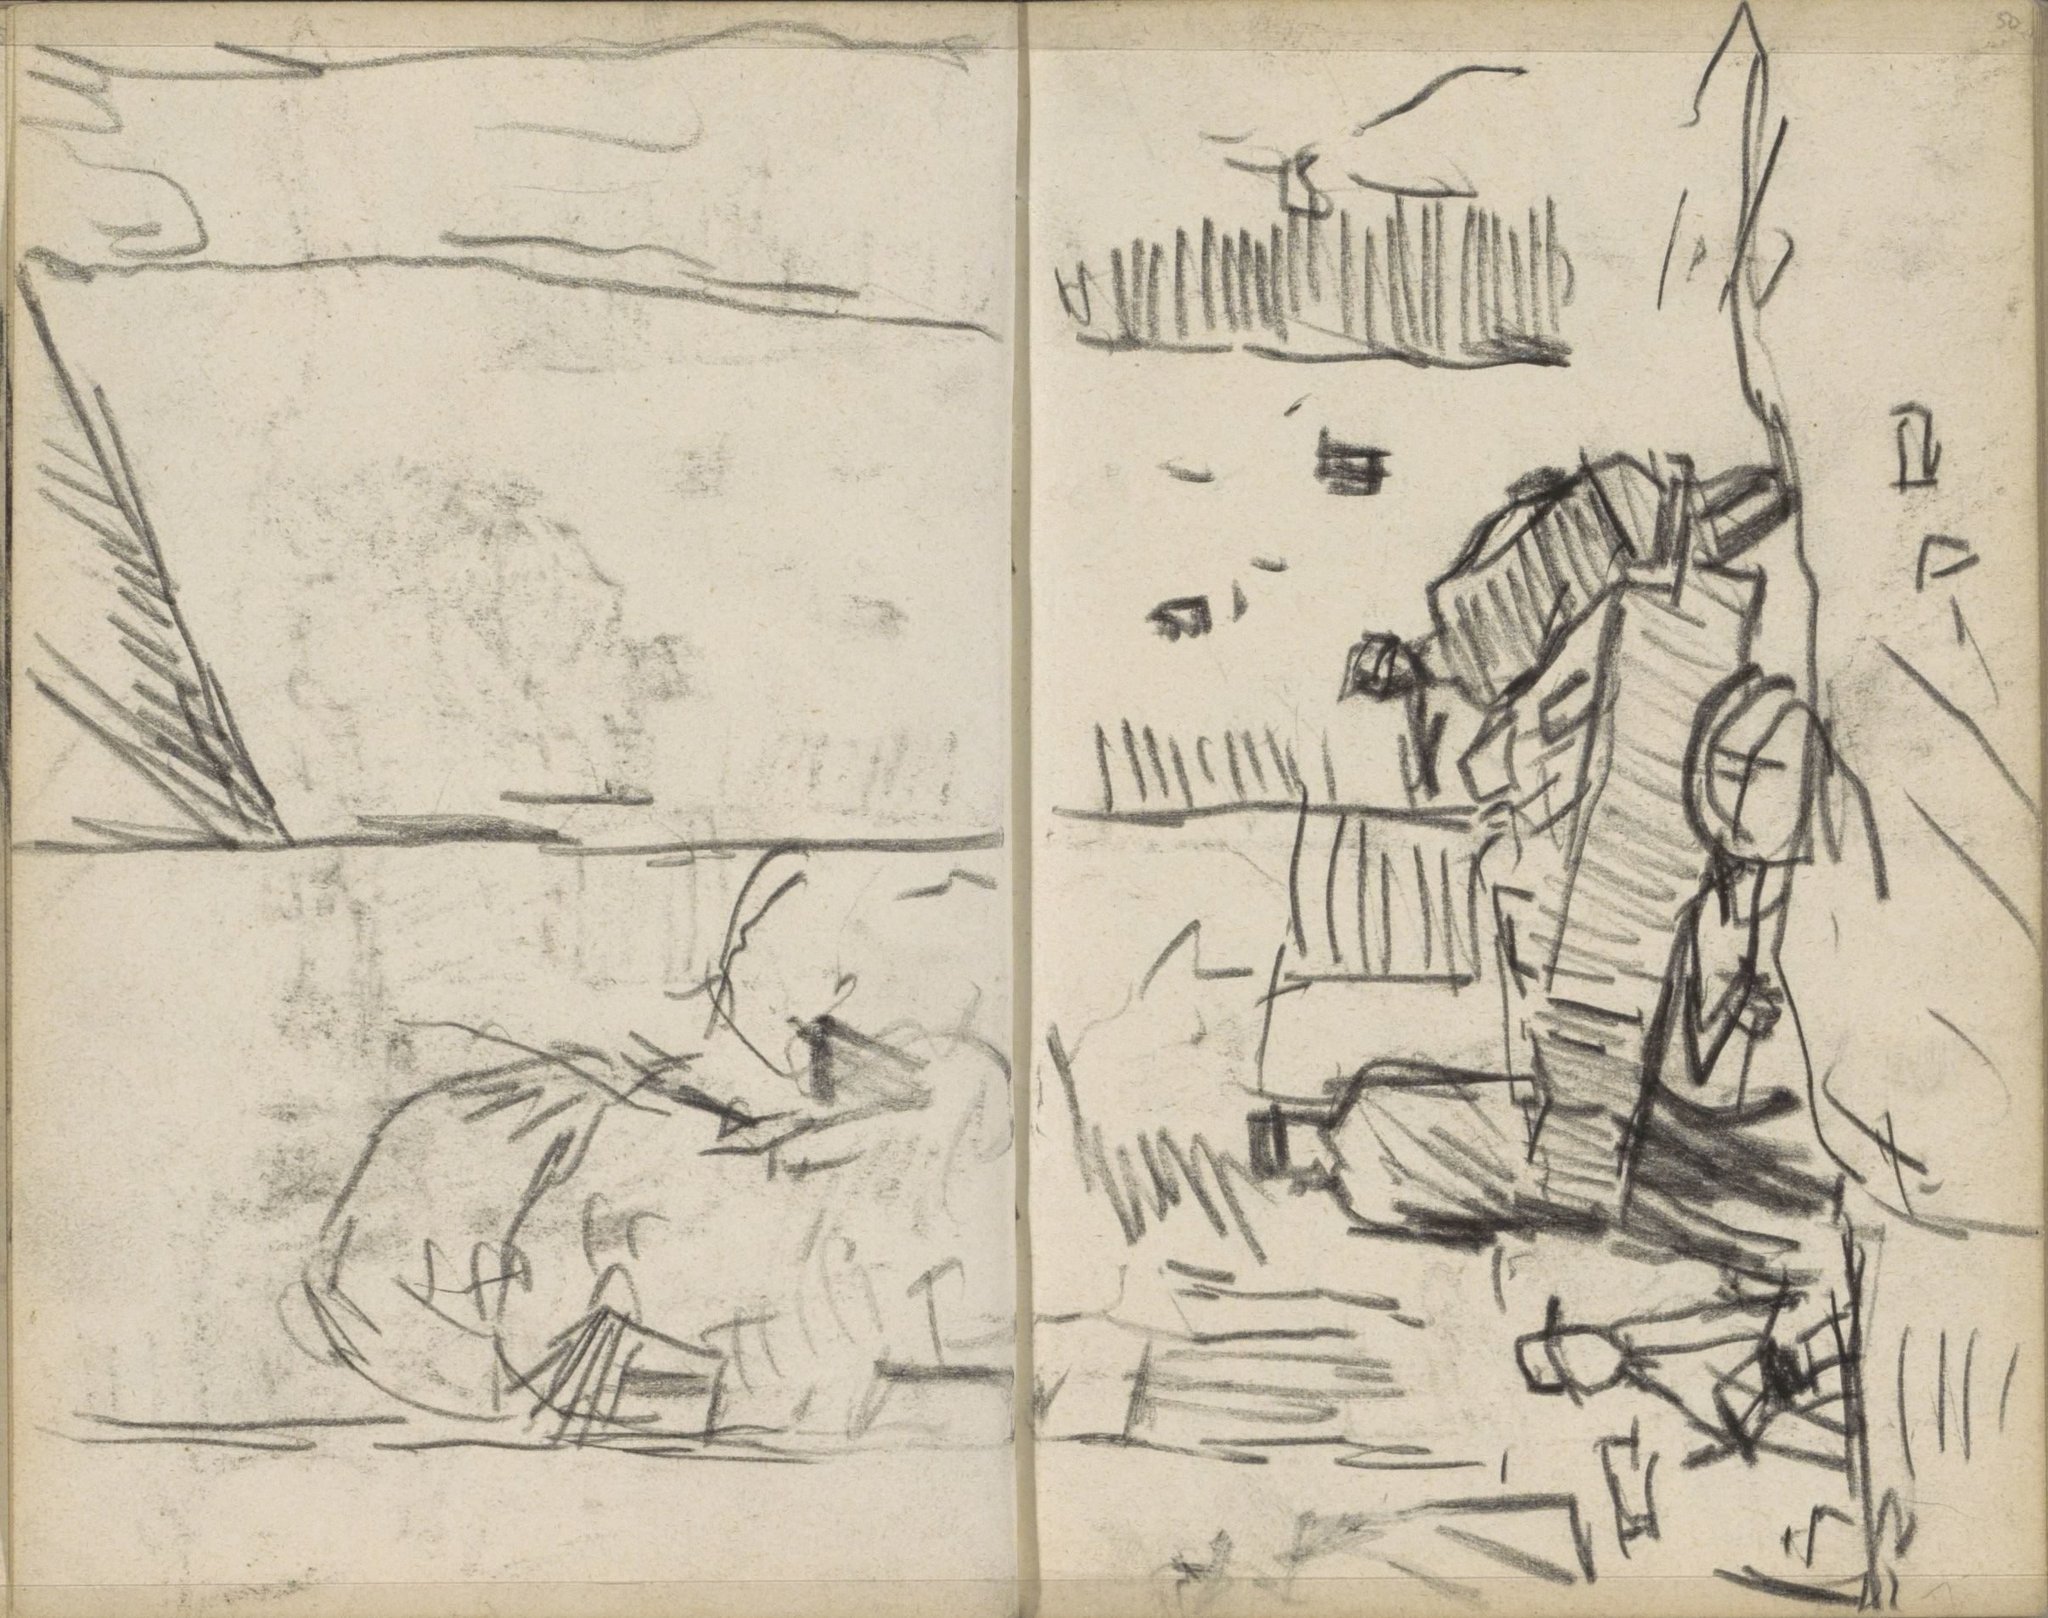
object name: sketchbook leaf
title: Kruiers, mogelijk in het Begijnhof te Amsterdam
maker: george hendrik breitner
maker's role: draughtsman, painter, print maker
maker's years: 1857-1923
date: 1907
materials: chalk, paper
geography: amsterdam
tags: urban housing, porter, bearer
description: Kruiers, mogelijk in het Begijnhof te Amsterdam. Pagina 49 en pagina 50 uit een schetsboek met 46 bladen vervaardigd in Amsterdam, Rotterdam en Haarlem.